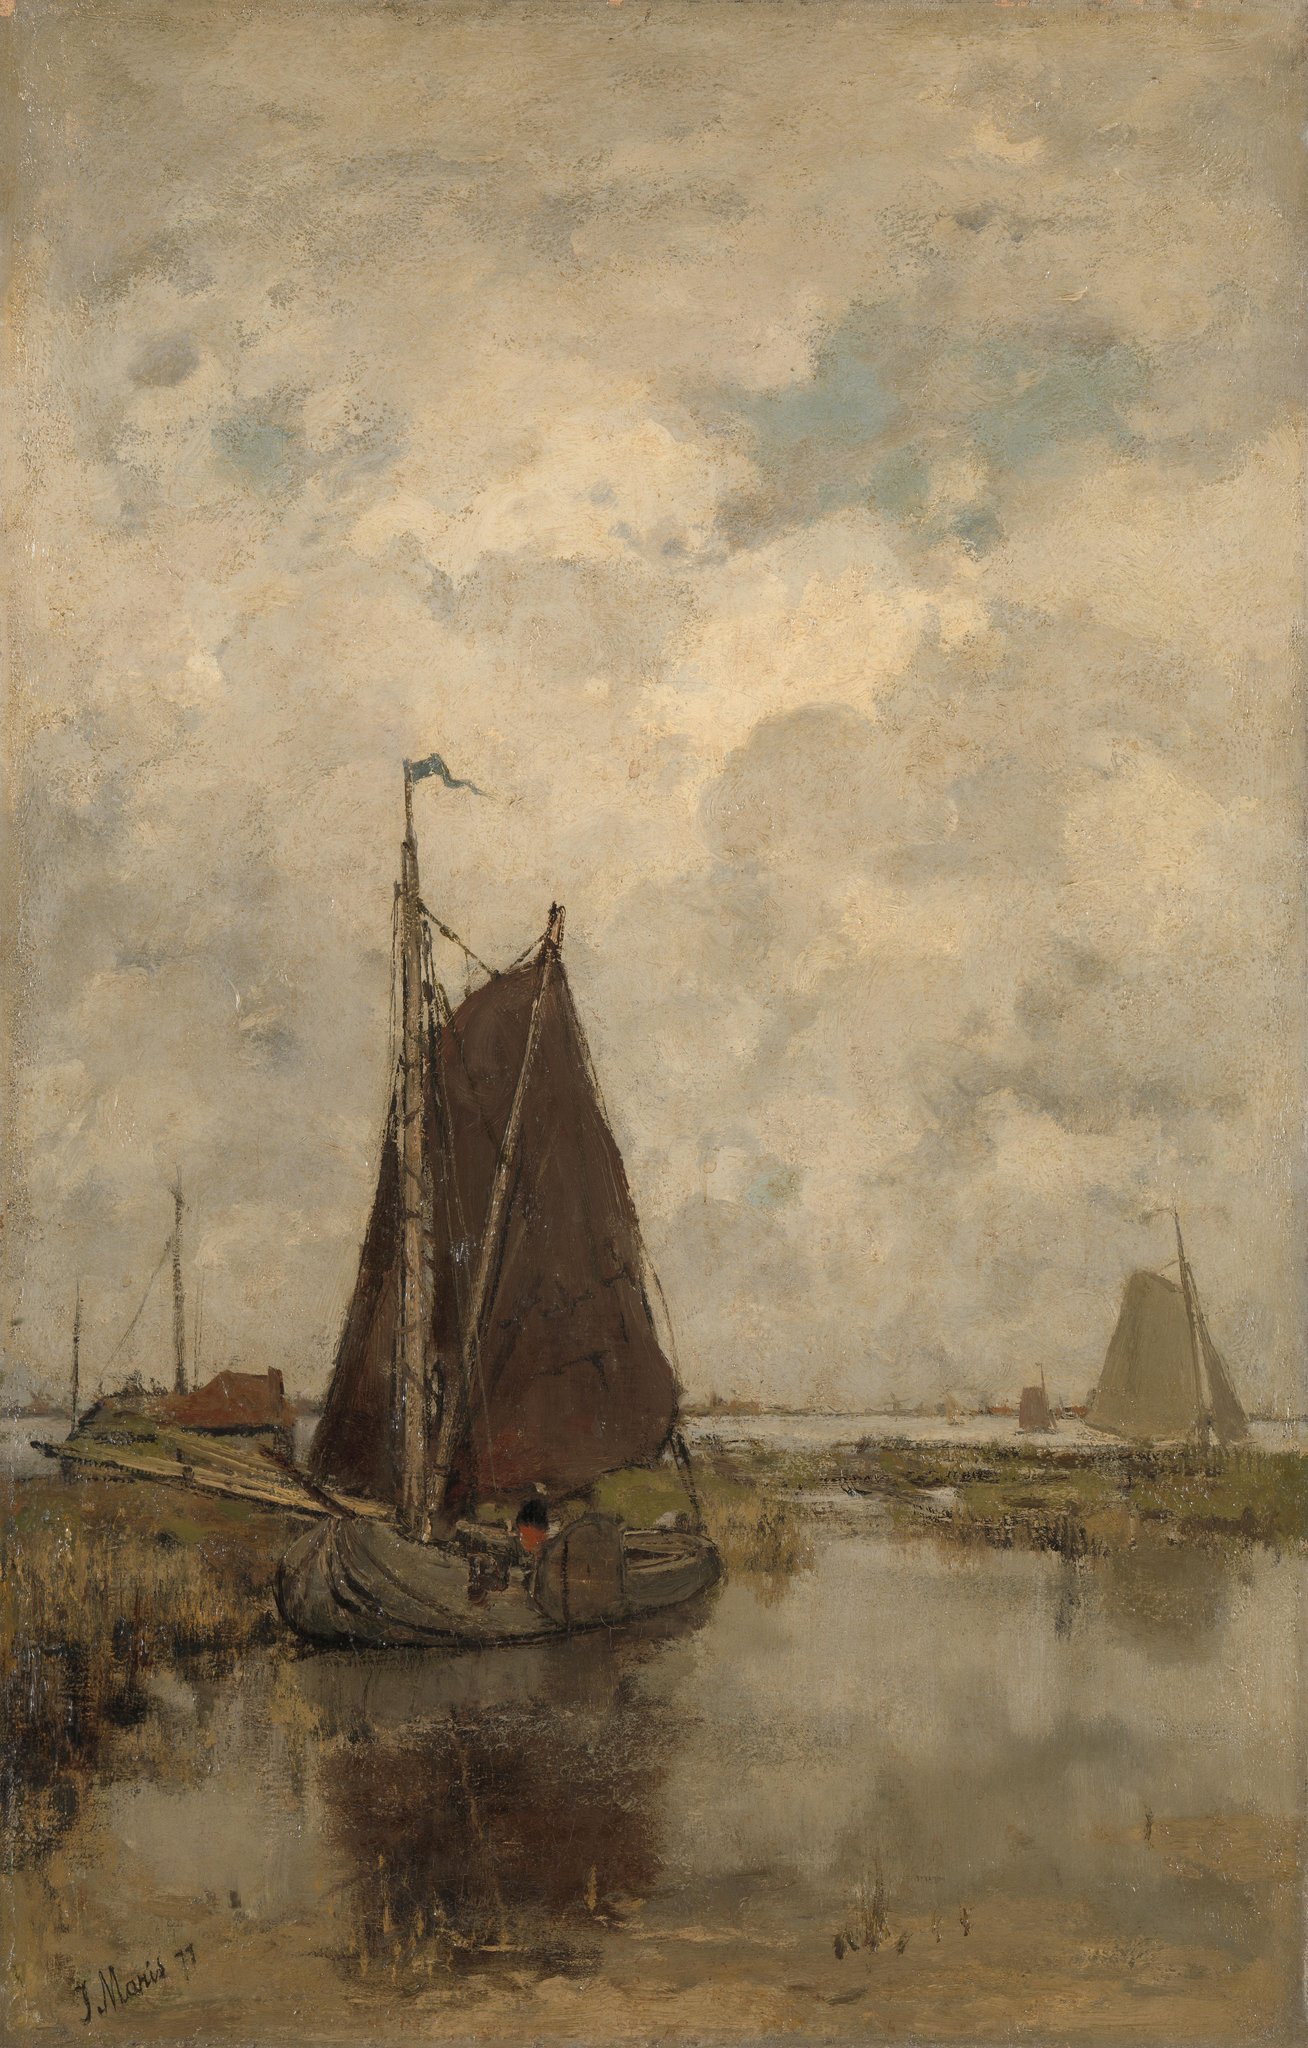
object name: painting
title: Ships in Dull Weather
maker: jacob maris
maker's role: draughtsman, painter, print maker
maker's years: 1837-1899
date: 1877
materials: canvas, oil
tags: sailing-ship, sailing-boat, lake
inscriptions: signature and date: ‘J. Maris 77’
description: Landschap met uitgestrekte plassen en enkele schepen onder een grijze wolkendek.